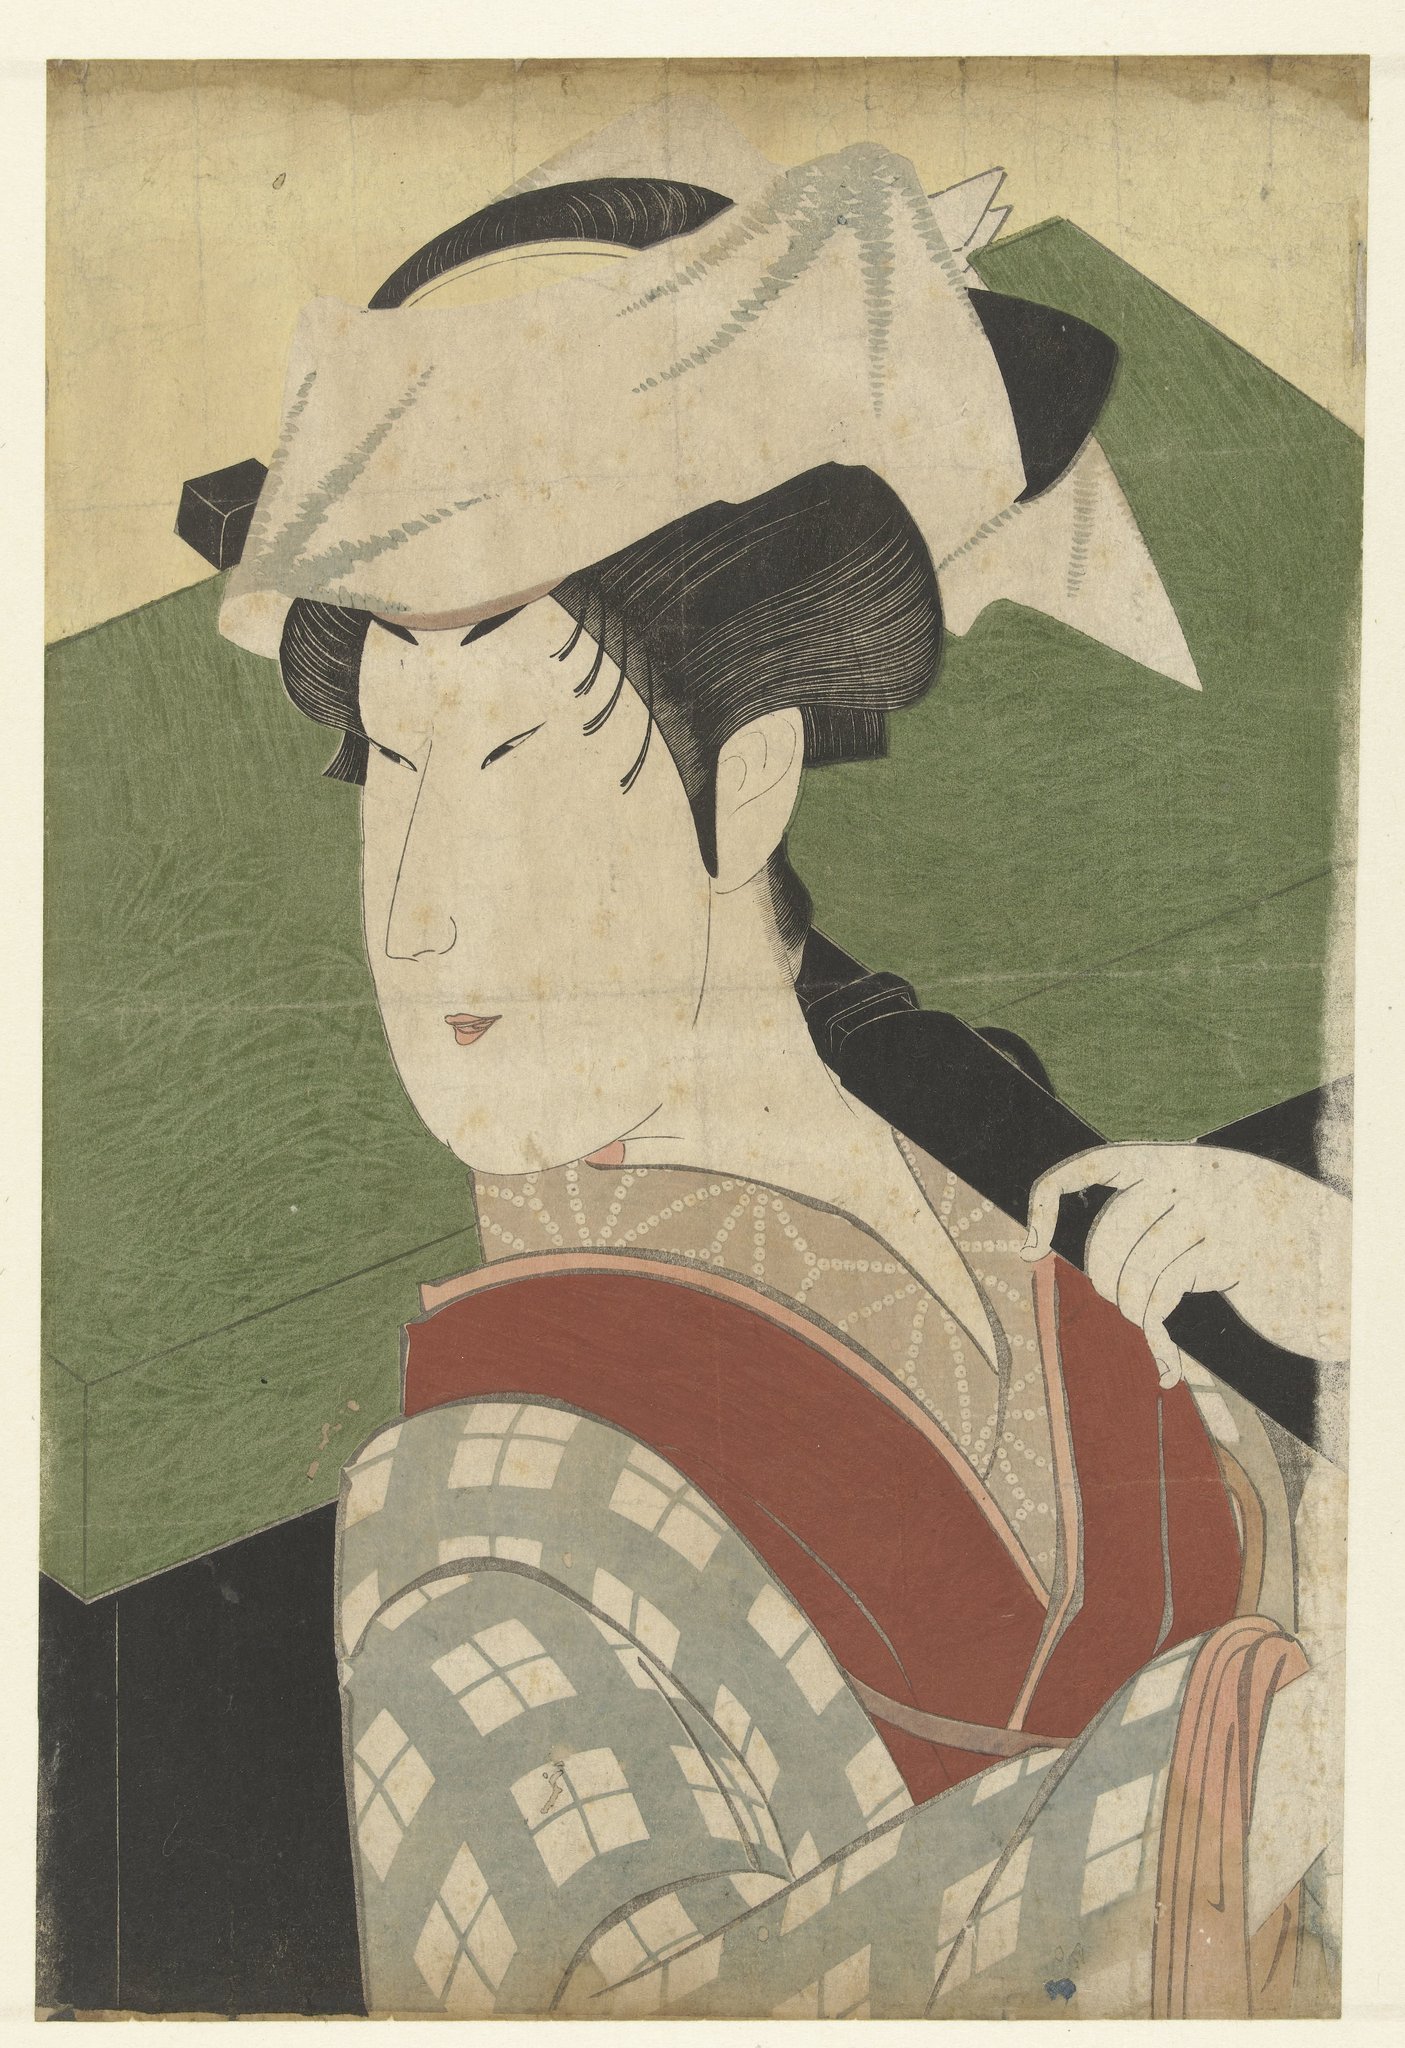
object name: print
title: Busteportret van Nakamura Noshio II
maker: utagawa kunimasa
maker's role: print maker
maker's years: 1773-1810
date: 1795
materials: paper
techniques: woodcut, nishiki e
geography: japan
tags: portrait of actor, actress, carrying something with yoke, chest, coffer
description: De acteur Nakamura Noshio II in vrouwenrol, als Tokujo, echtgenote van Gotobei, in geruite kimono, een grote kist aan een juk over de schouder dragend.